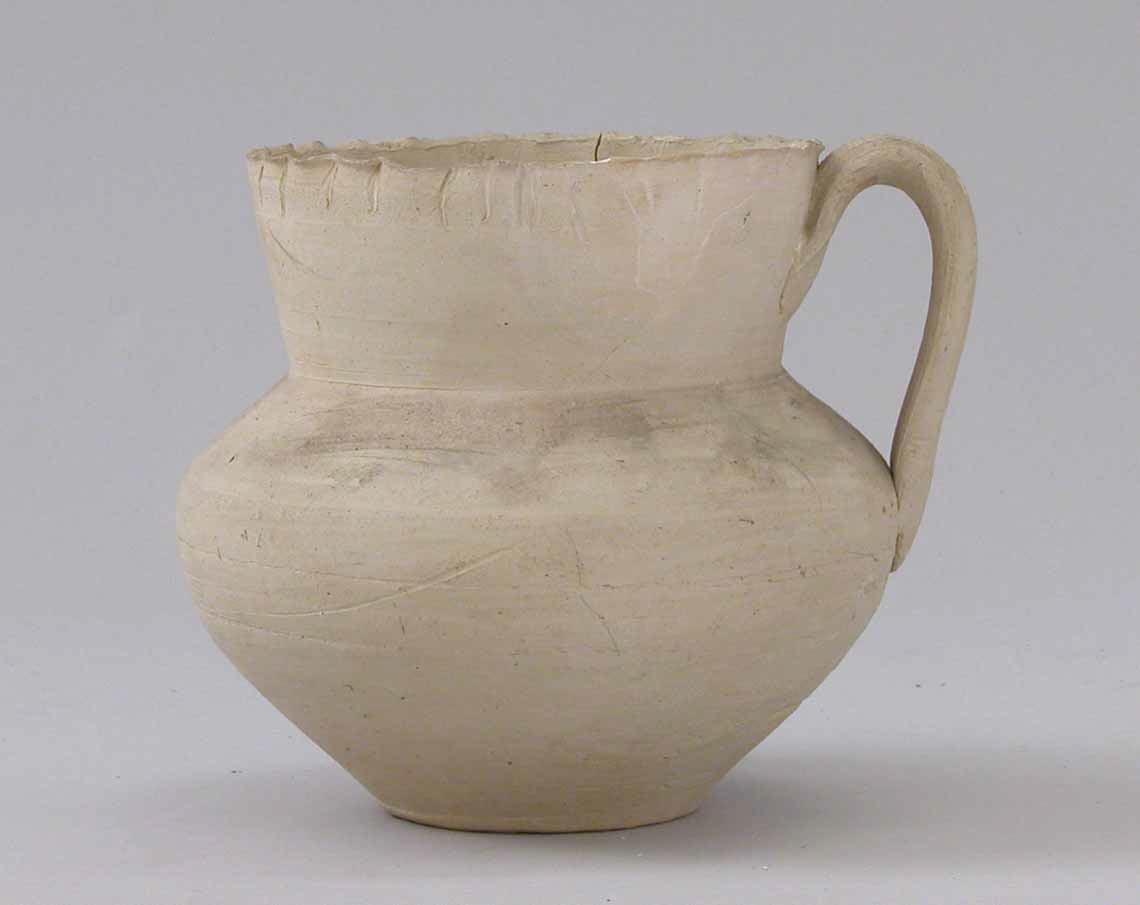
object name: ewer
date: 801-1000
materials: earthenware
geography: iran